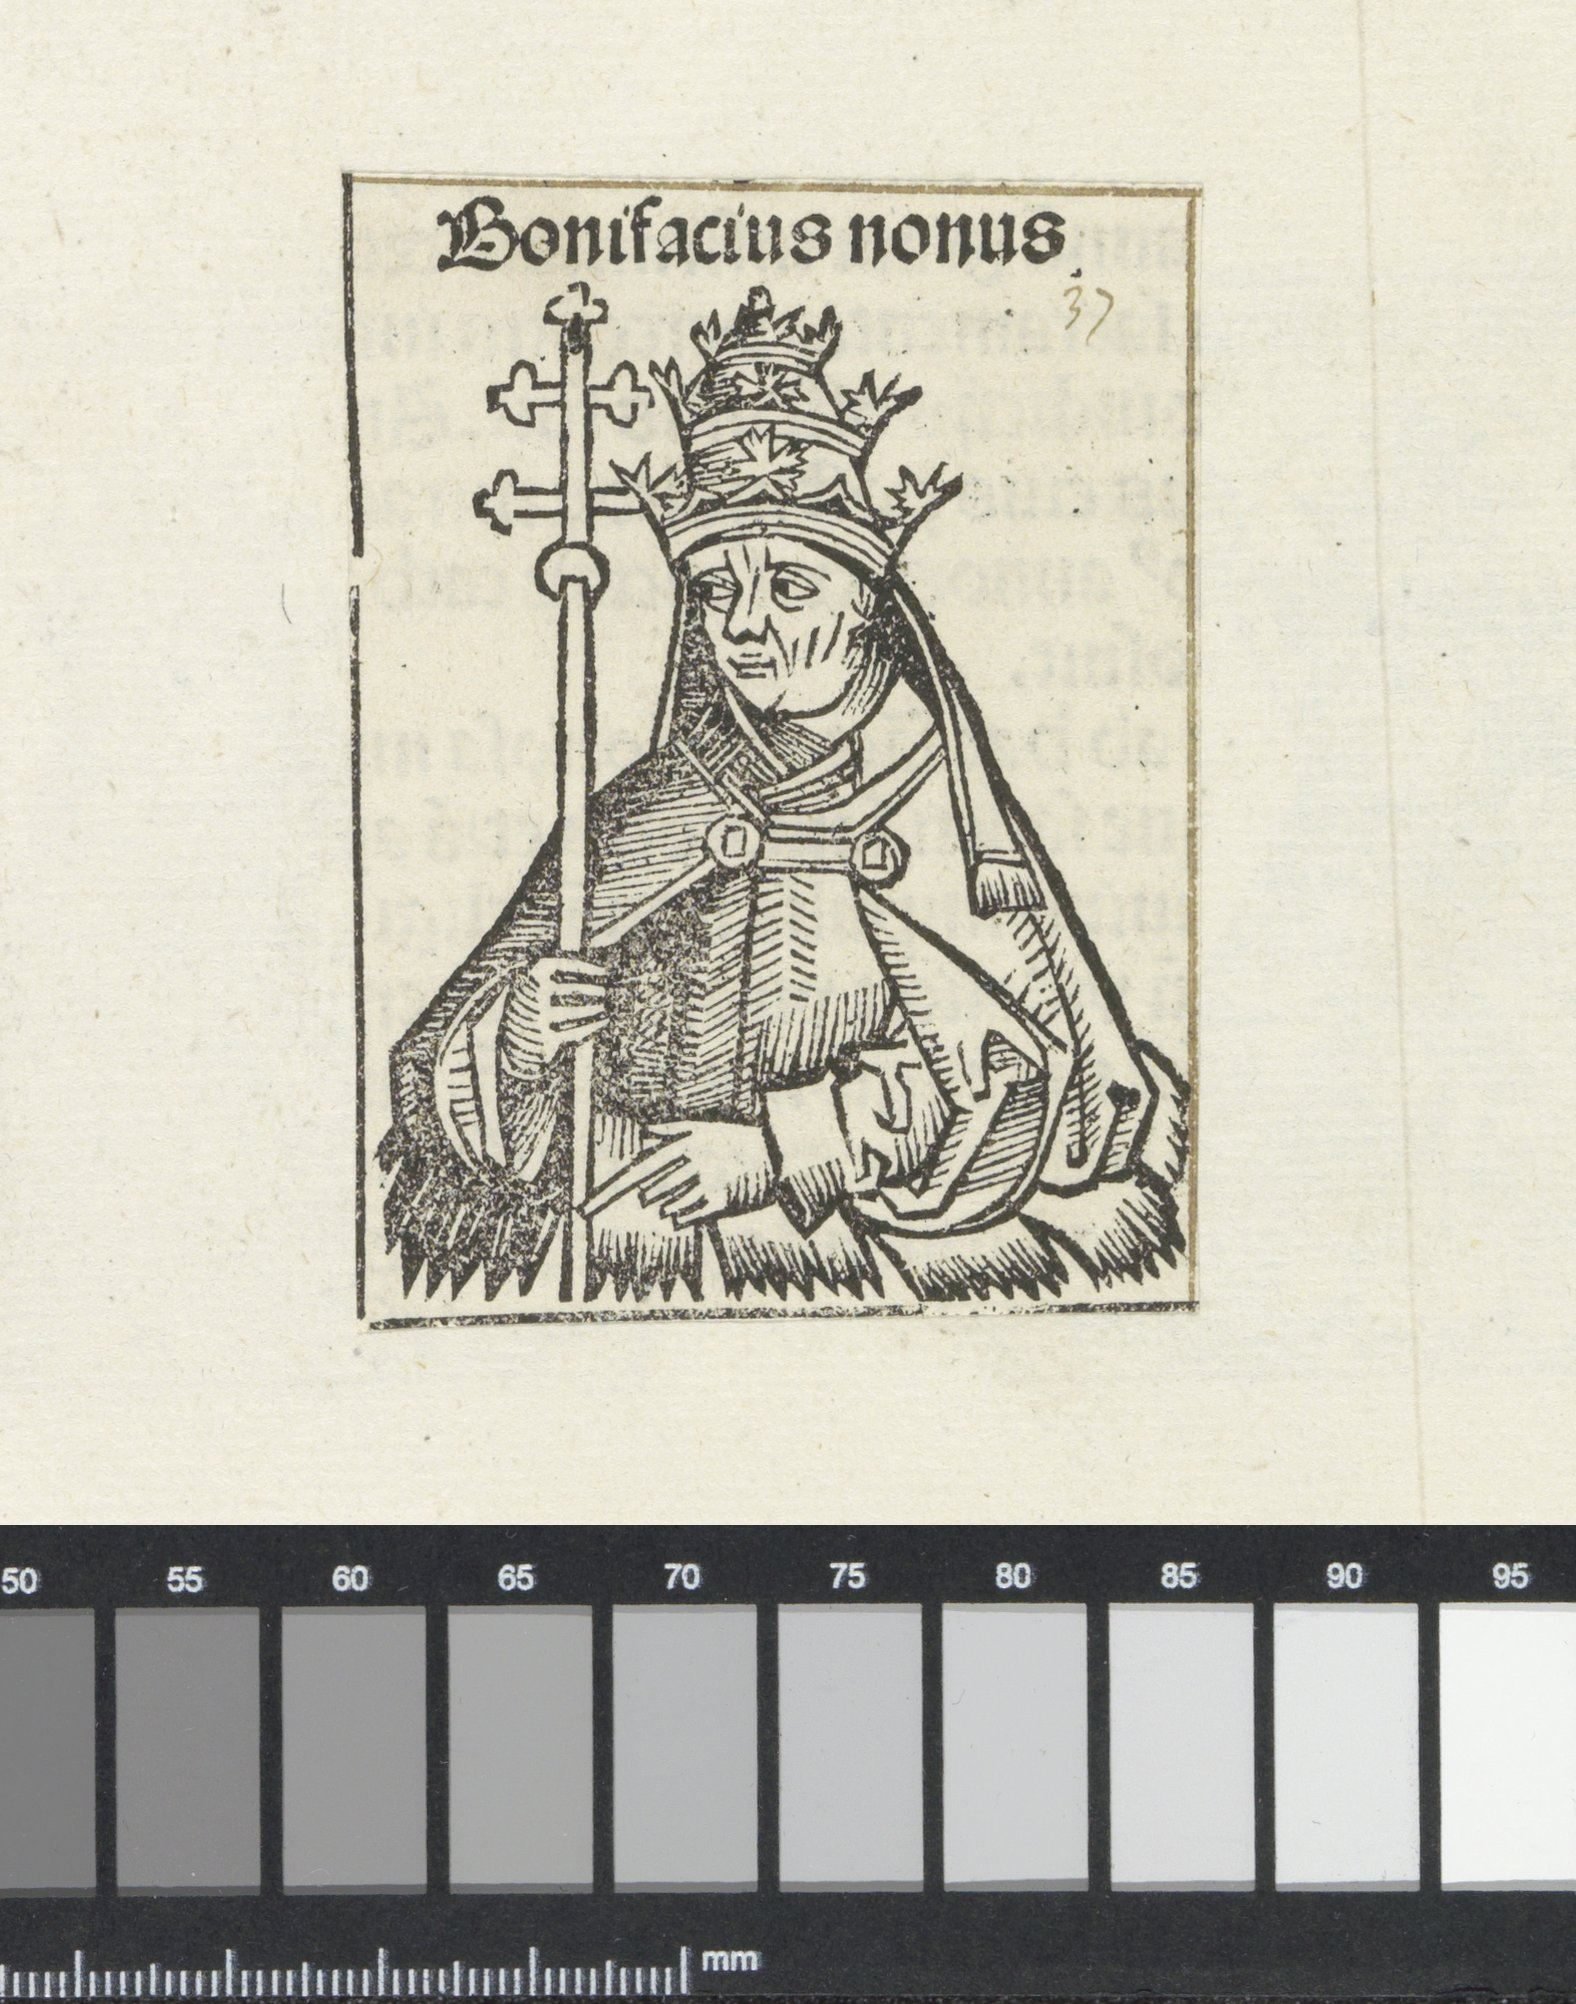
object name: album leaf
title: Liber Chronicarum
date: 1493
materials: paper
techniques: letterpress printing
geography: nuremberg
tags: pope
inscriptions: inscription: ‘37’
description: Een bloemkelk met een paus. Hij draagt een tiara en heeft een staf met een dubbel kruis in zijn handen. De voorstelling is onderdeel van de opeenvolging pausen in de Liber Chronicarum. De tekst identificeert de man als Bonifatius IX. De prent maakt deel uit van een album.